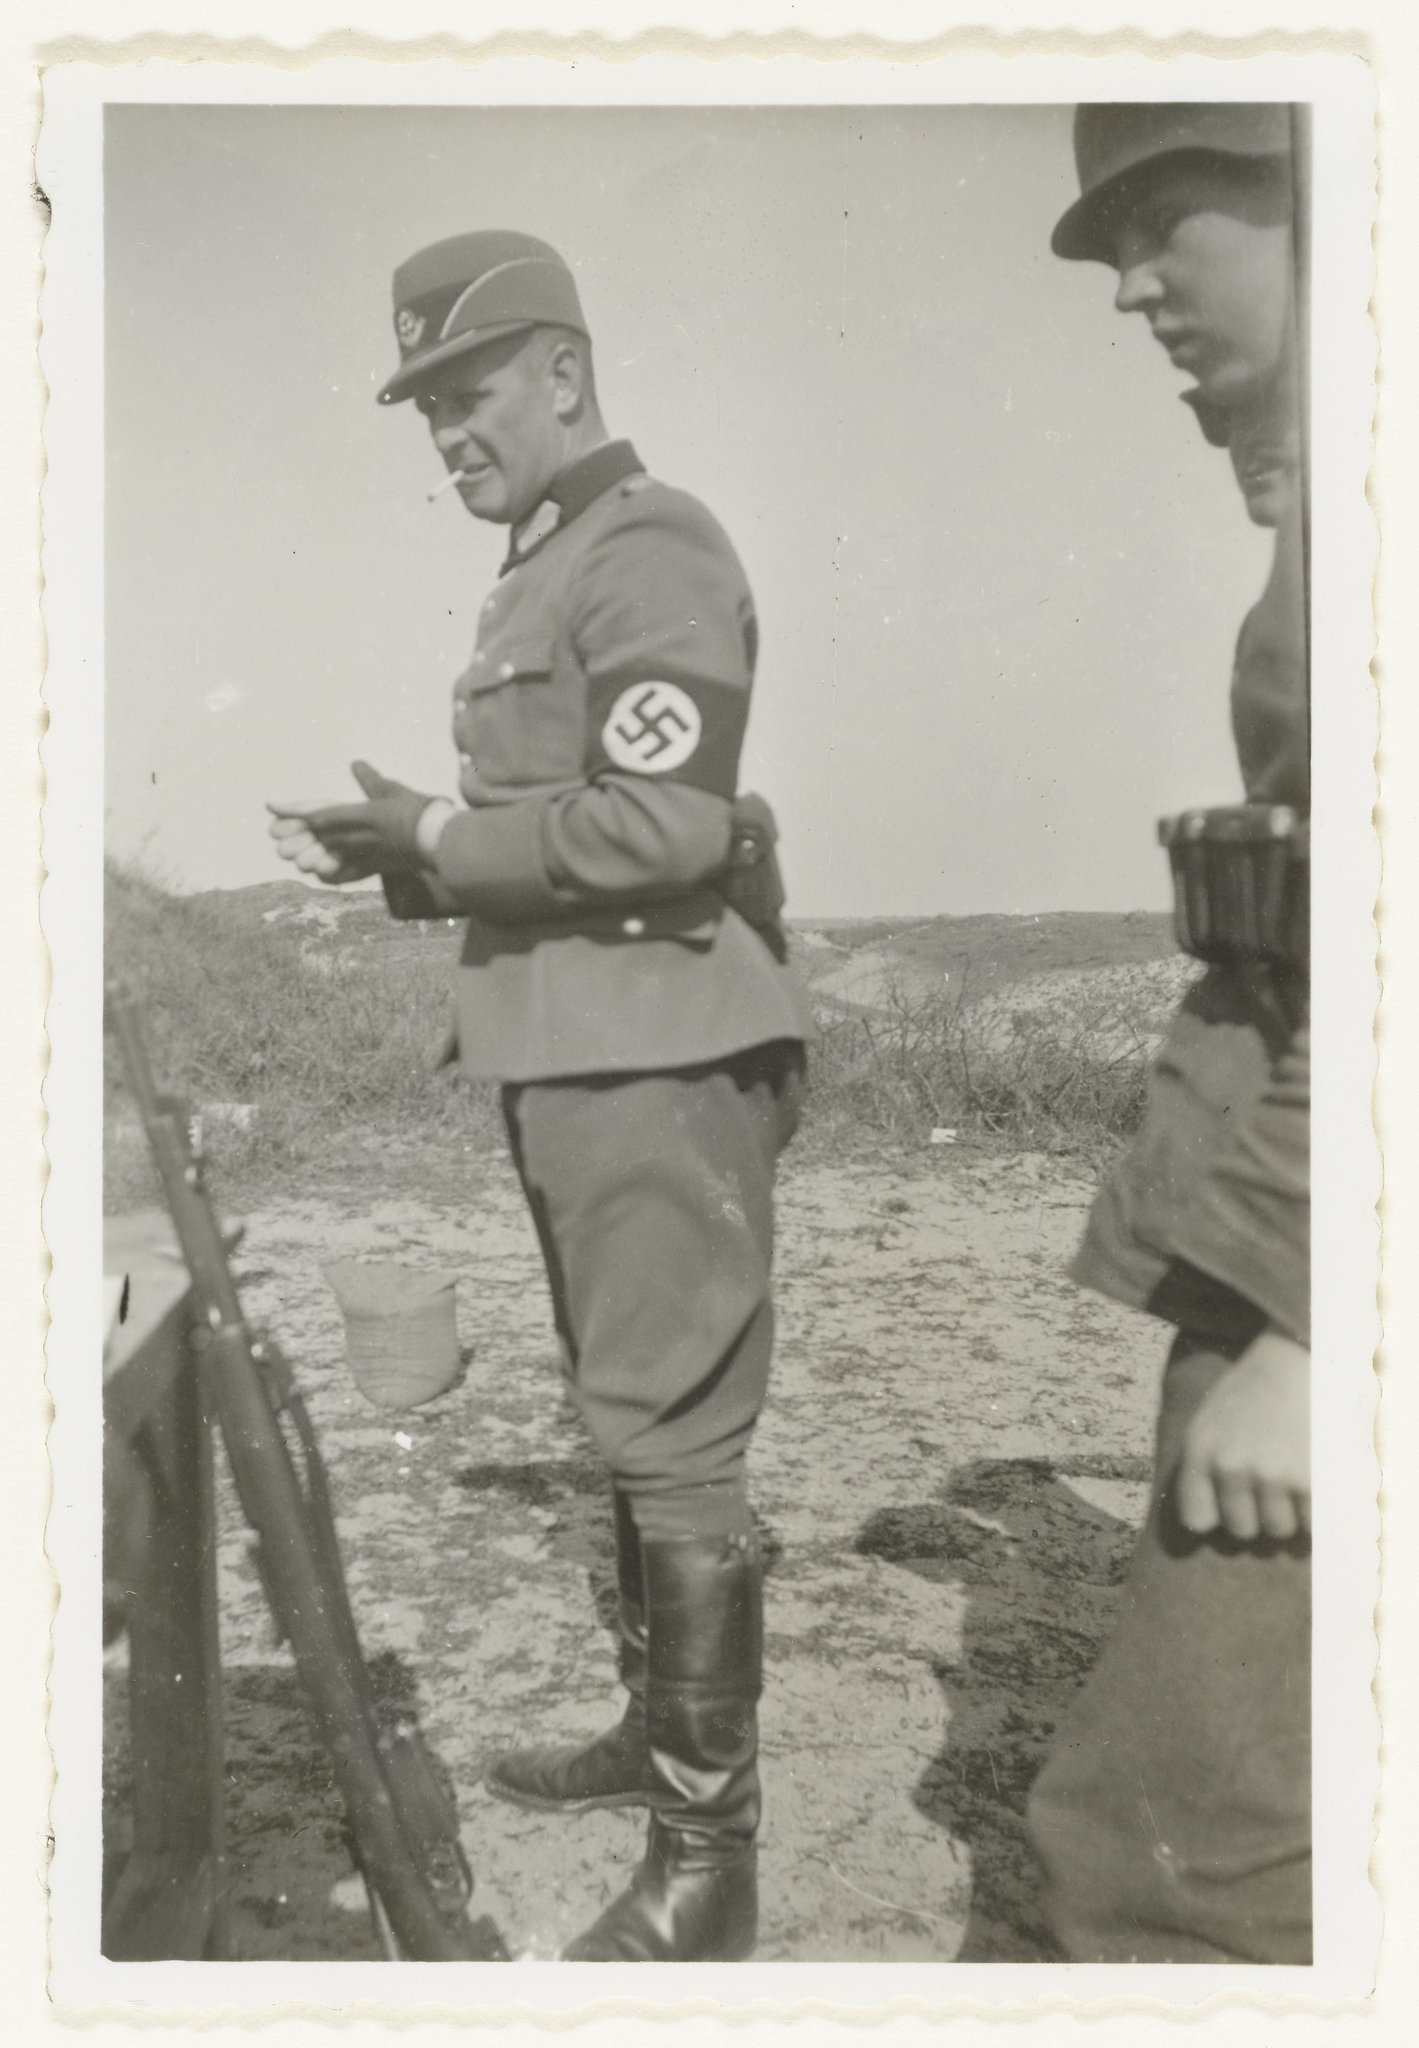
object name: photograph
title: Lid van de Reichsarbeitsdienst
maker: Anonymous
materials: photographic support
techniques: gelatin silver print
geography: netherlands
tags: occupation ~ war, netherlands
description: Een lid van de SS met een doodskop embleem op zijn pet en een hakenkruisband om zijn arm staat ergens in de duinen. Links van hem een paar geweren, rechts van hem een Wehrmacht militair. Achterop staat: Abteilungsführer Oberstfeldmstr. Ewers